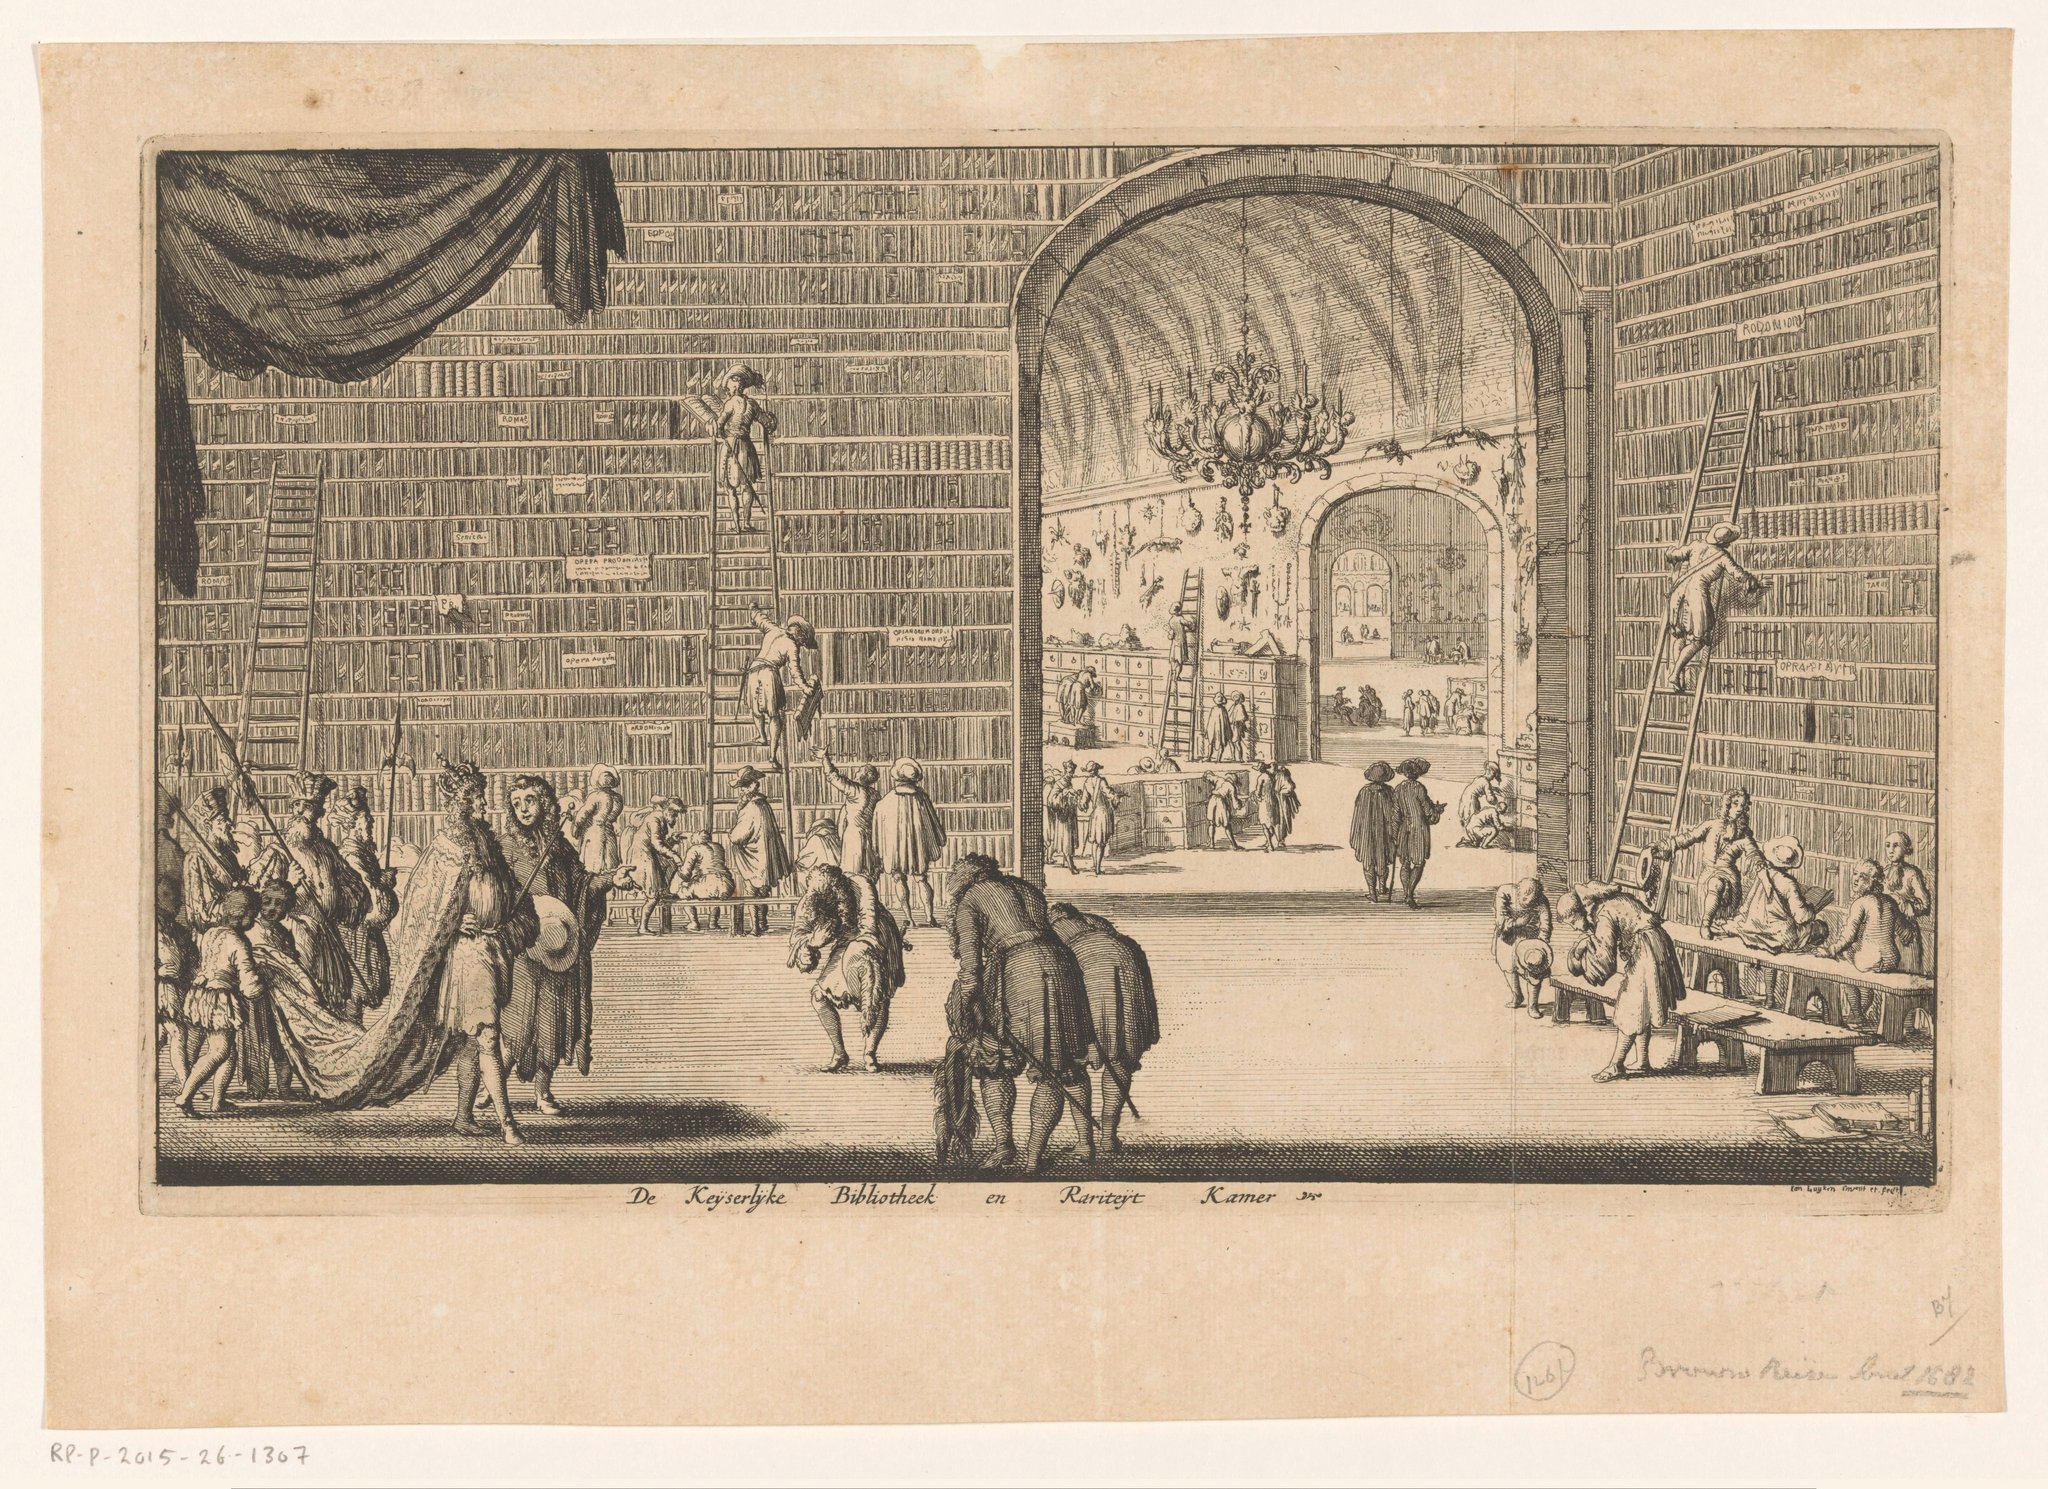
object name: print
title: Keizerlijke bibliotheek en rariteitenkabinet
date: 1682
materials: paper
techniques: etching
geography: amsterdam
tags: study; 'studiolo'; library, cabinet of curiosities, 'kunst- und wunderkammer'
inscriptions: collector's mark: Lugt 2228, collector's mark: ‘S.J. Robitsch 's-Gravenhage’, collector's mark: Lugt 4780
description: Illustratie opgenomen in: Brown, Edward. Naauwkeurige en gedenkwaardige reysen van Edward Brown (...) door Nederland, Duytsland, Hongaryen, Boek III, p. 24. Amsterdam: Jan Claesz ten Hoorn, 1682.